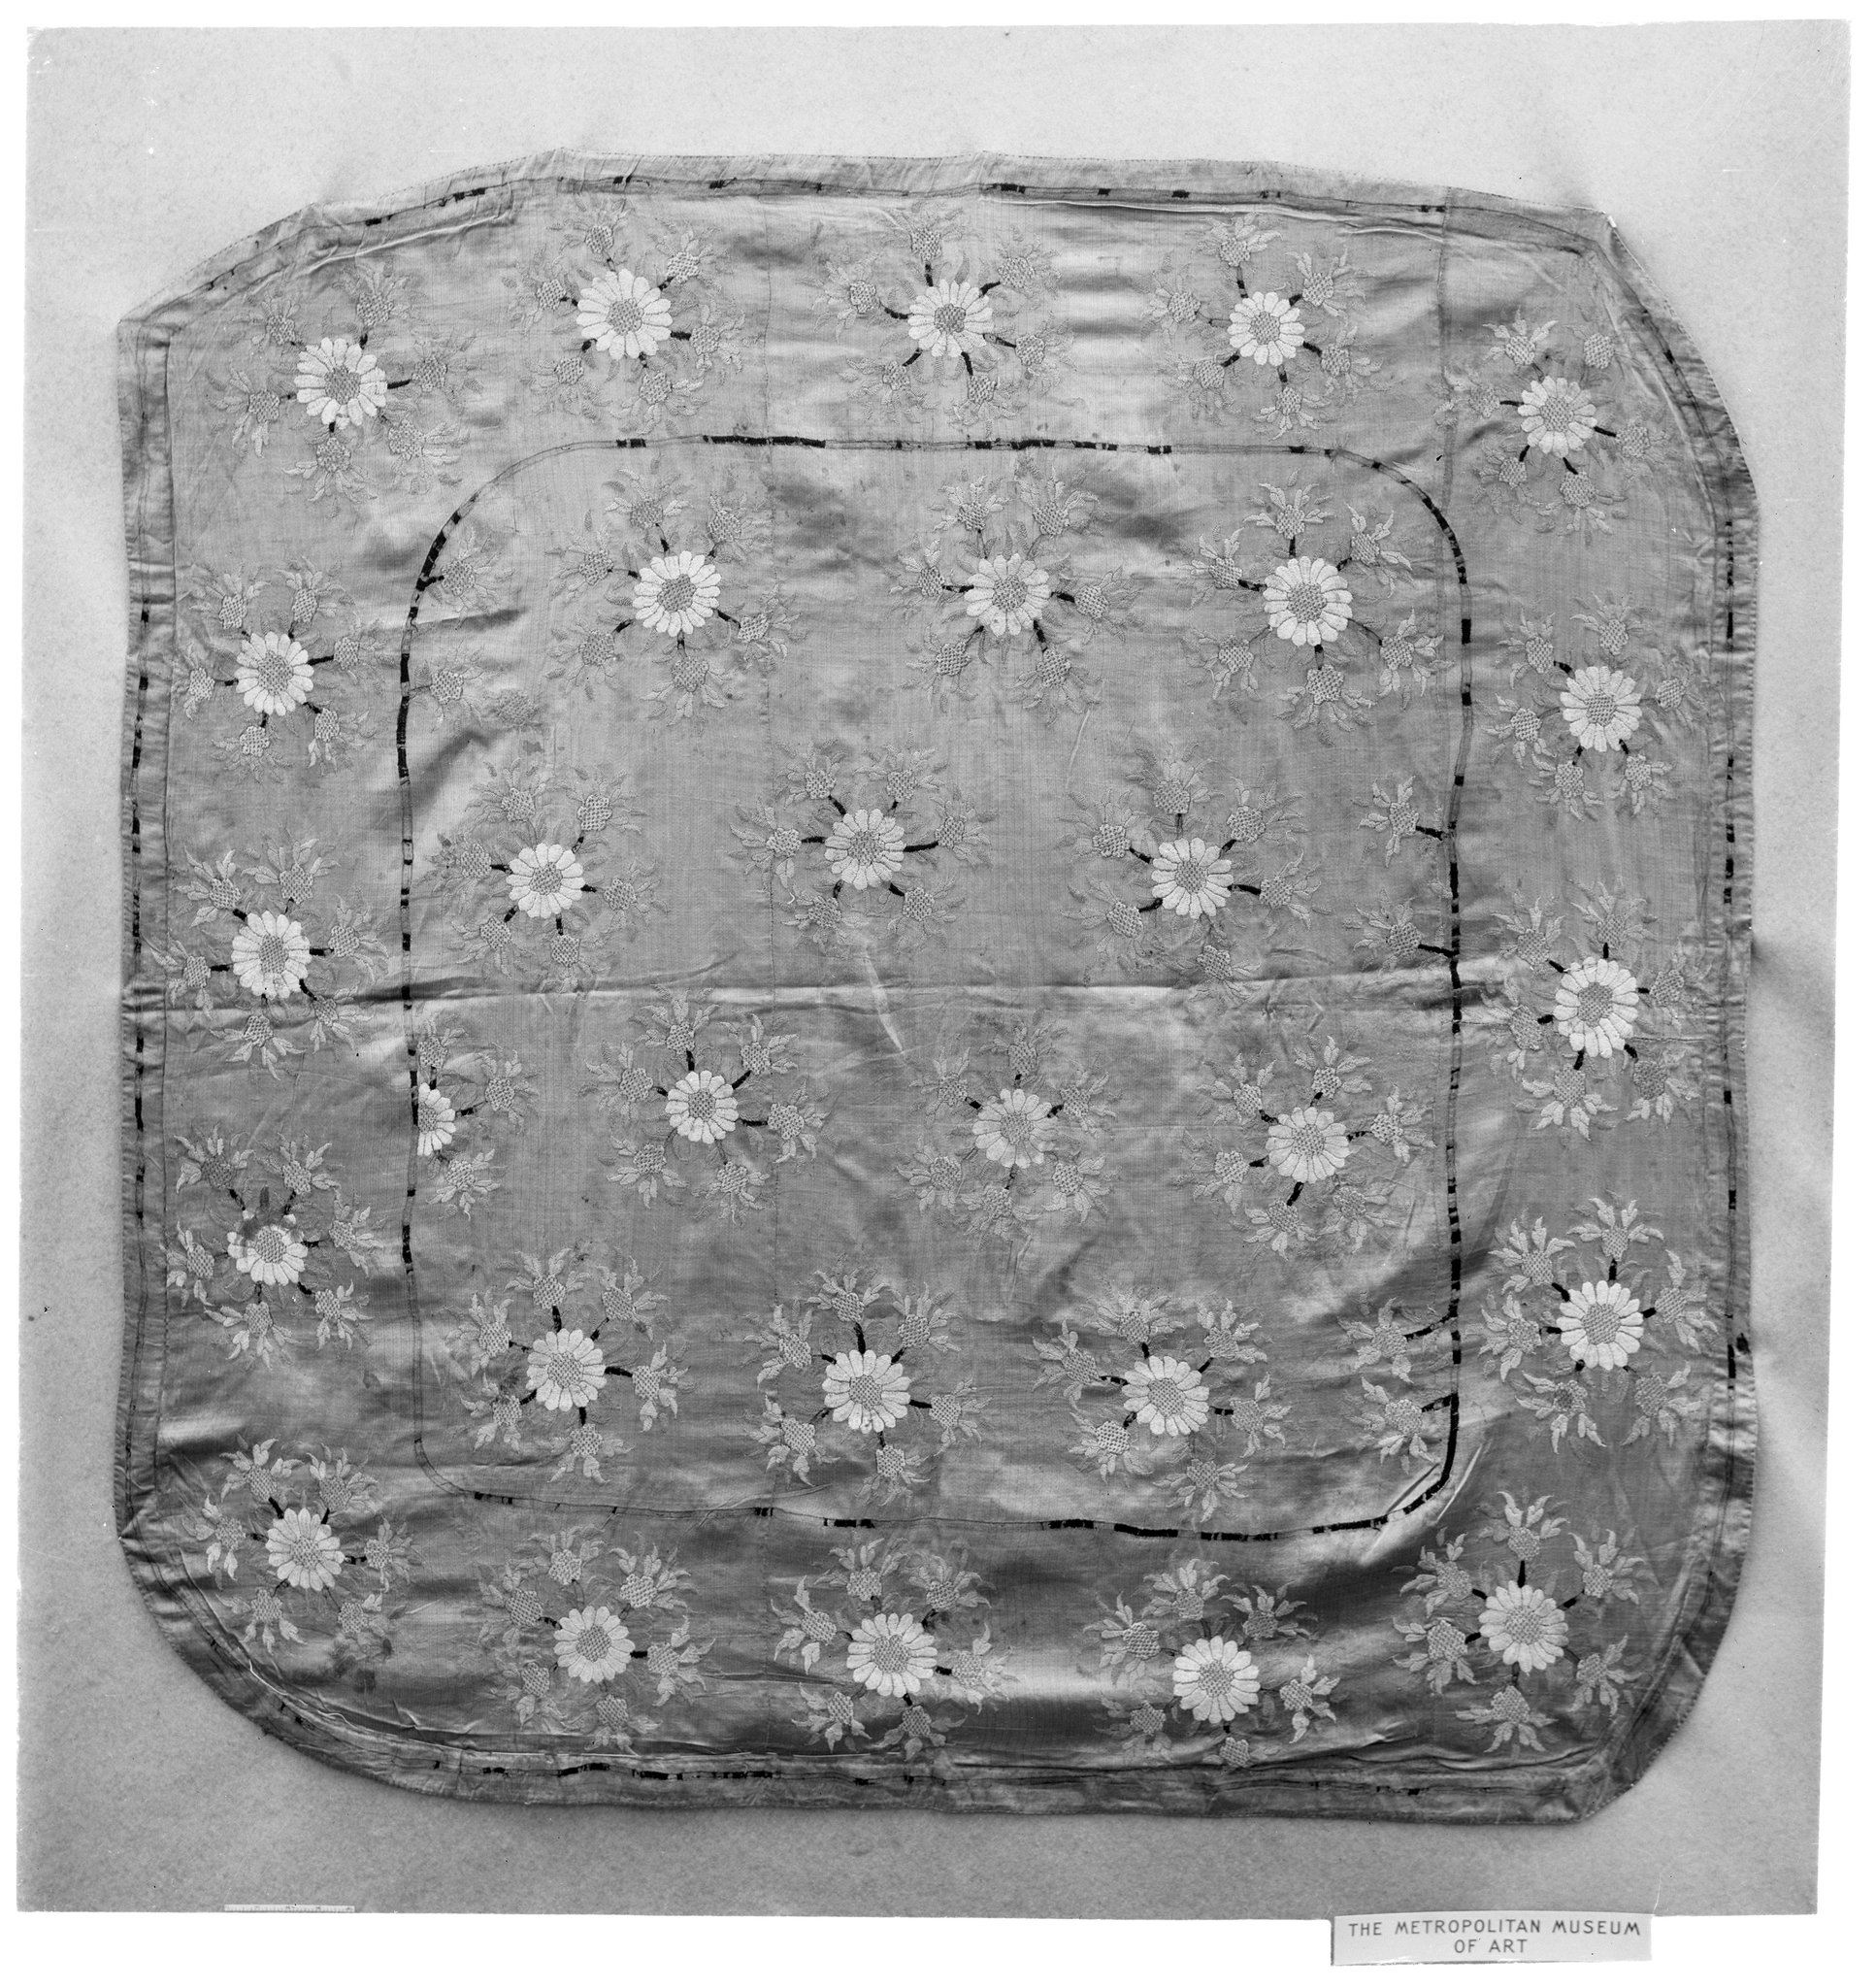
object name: cover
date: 1801-1833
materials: silk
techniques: embroidery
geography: turkey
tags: flowers